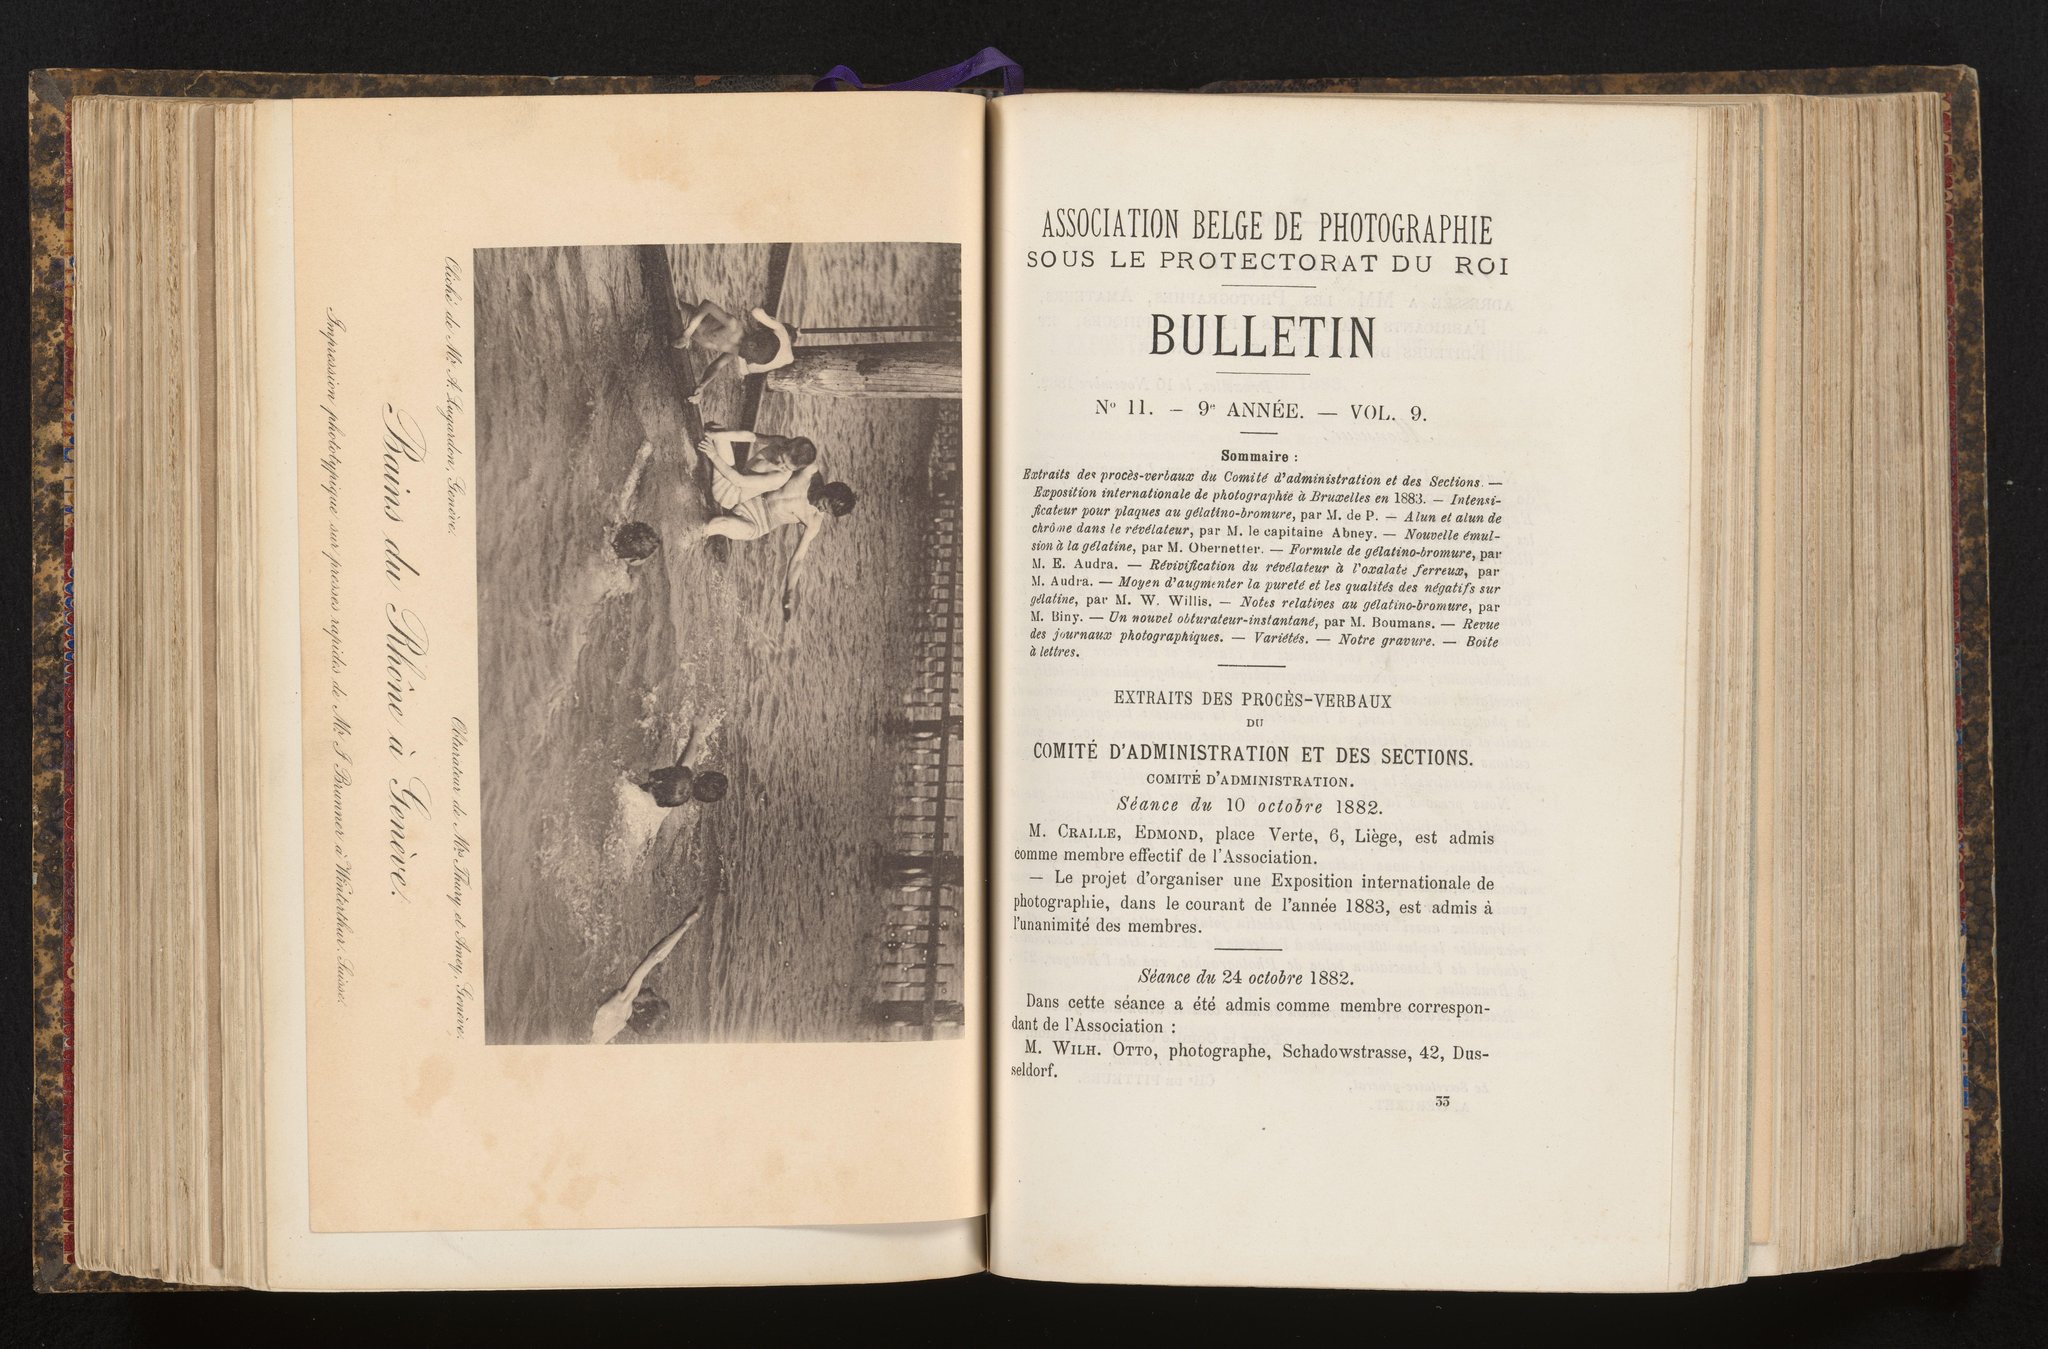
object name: photomechanical print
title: Onbekende jongens die in de Rhône zwemmen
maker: albert lugardon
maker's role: print maker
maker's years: 1827-1909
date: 1878-1883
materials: paper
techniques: photograph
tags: boy (child between toddler and youth), swimming (movement in water)